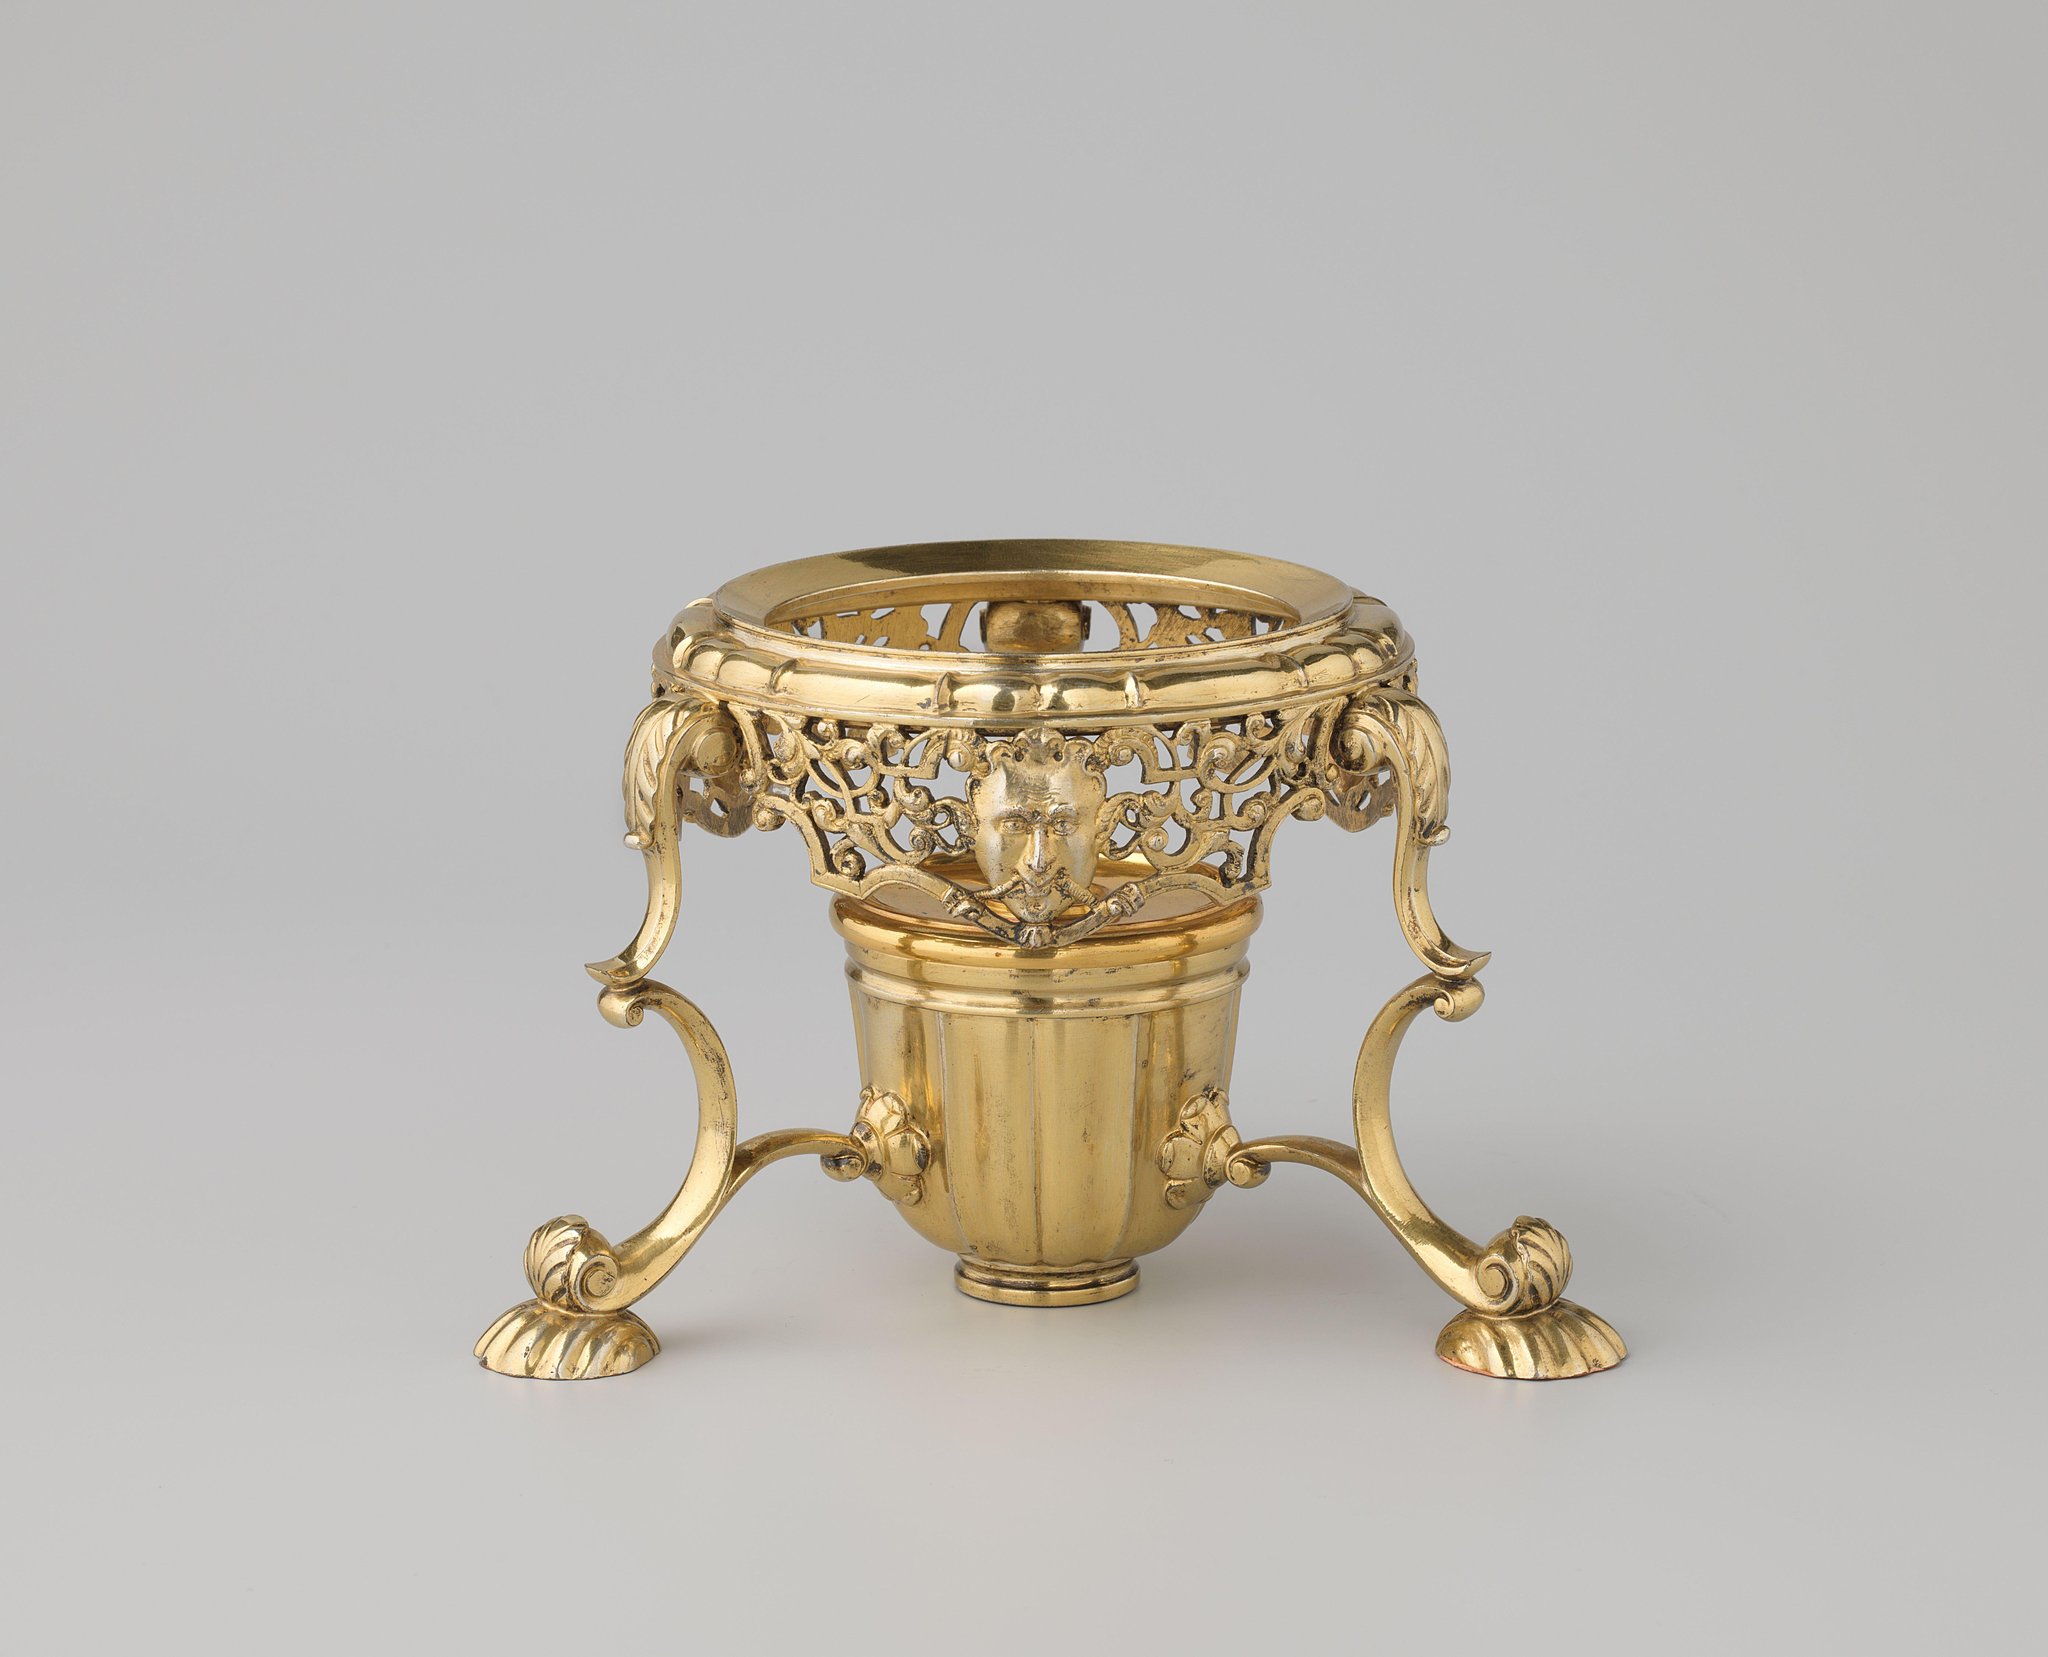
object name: komfoor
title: Galvanoplastische reproductie van een komfoor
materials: copper, silver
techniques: gilding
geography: london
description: Galvanoplastische reproductie van een komfoor. Verguld.